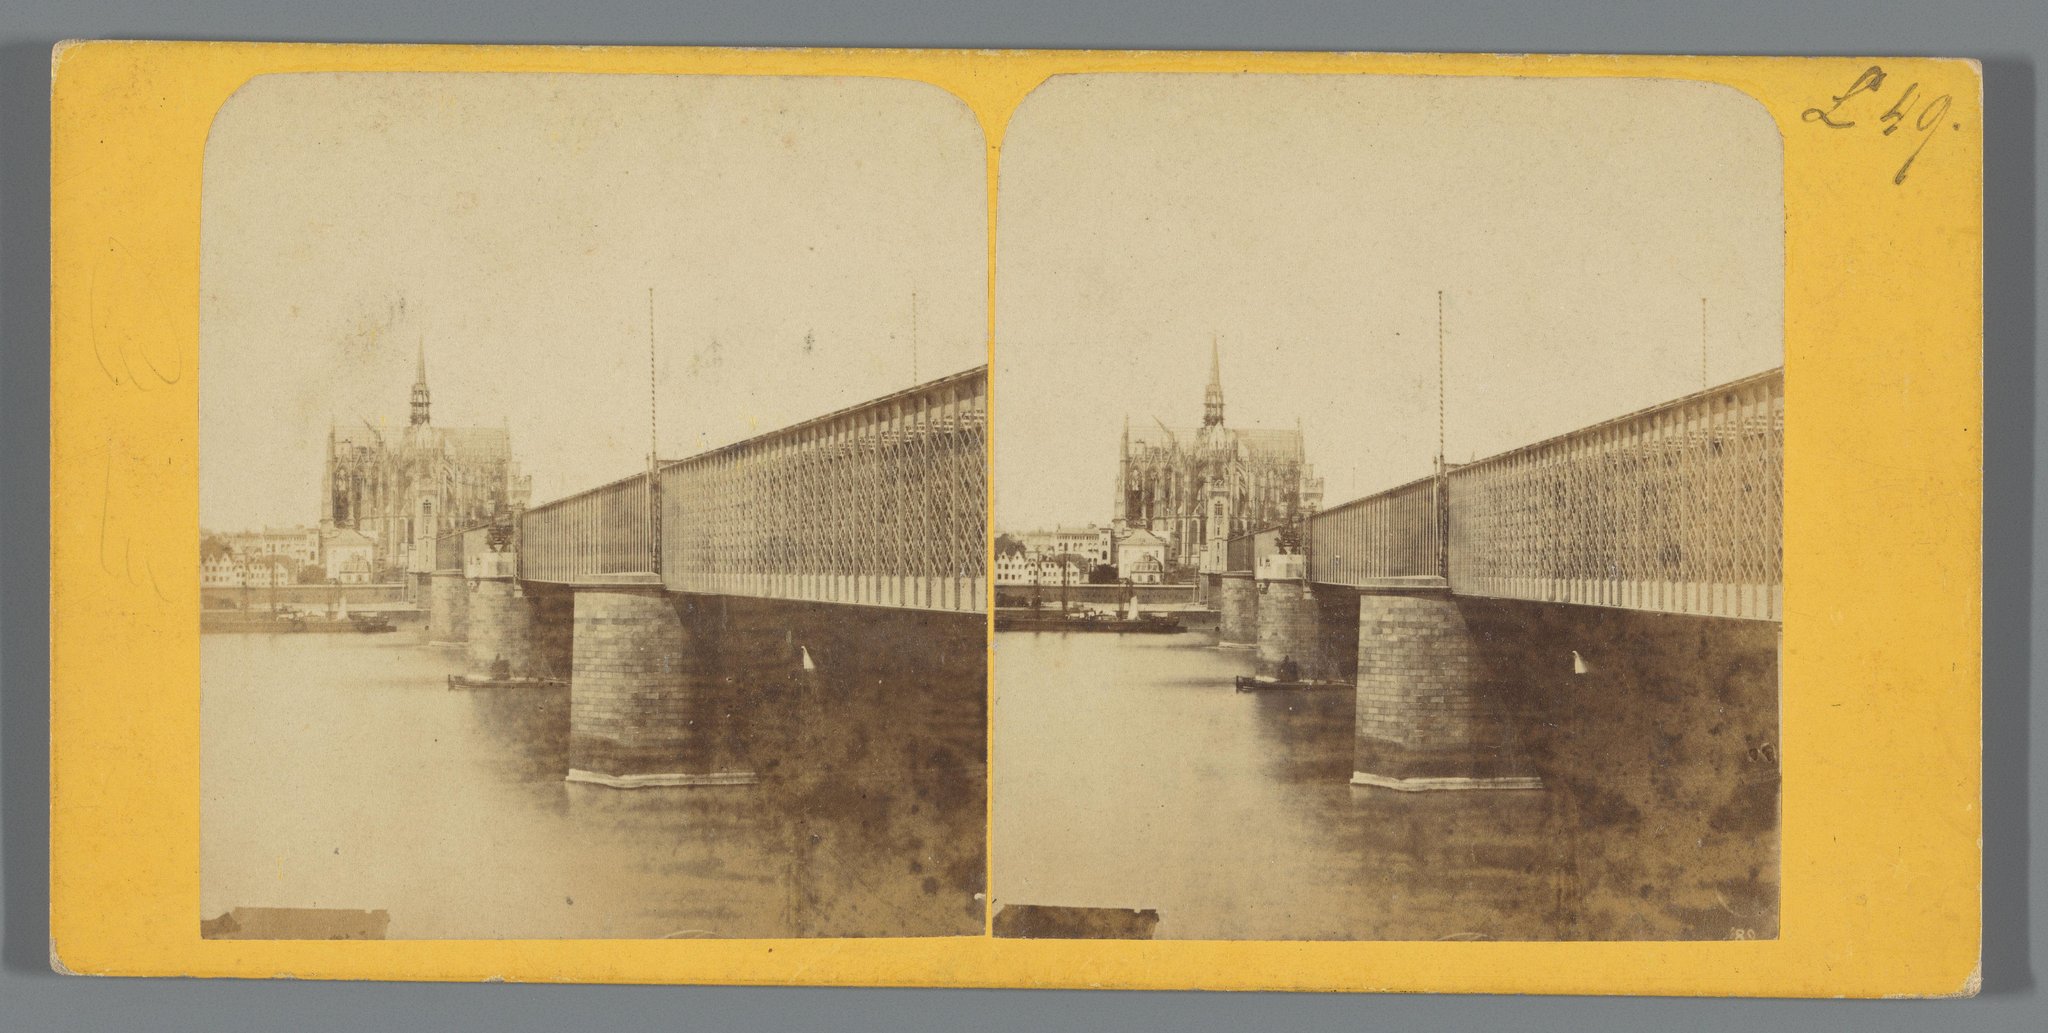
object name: stereograph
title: Cologne (Prusse)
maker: Anonymous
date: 1861-1870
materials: cardboard, paper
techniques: albumen print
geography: cologne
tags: church (exterior)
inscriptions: number: ‘-489-’, number: ‘L49.’